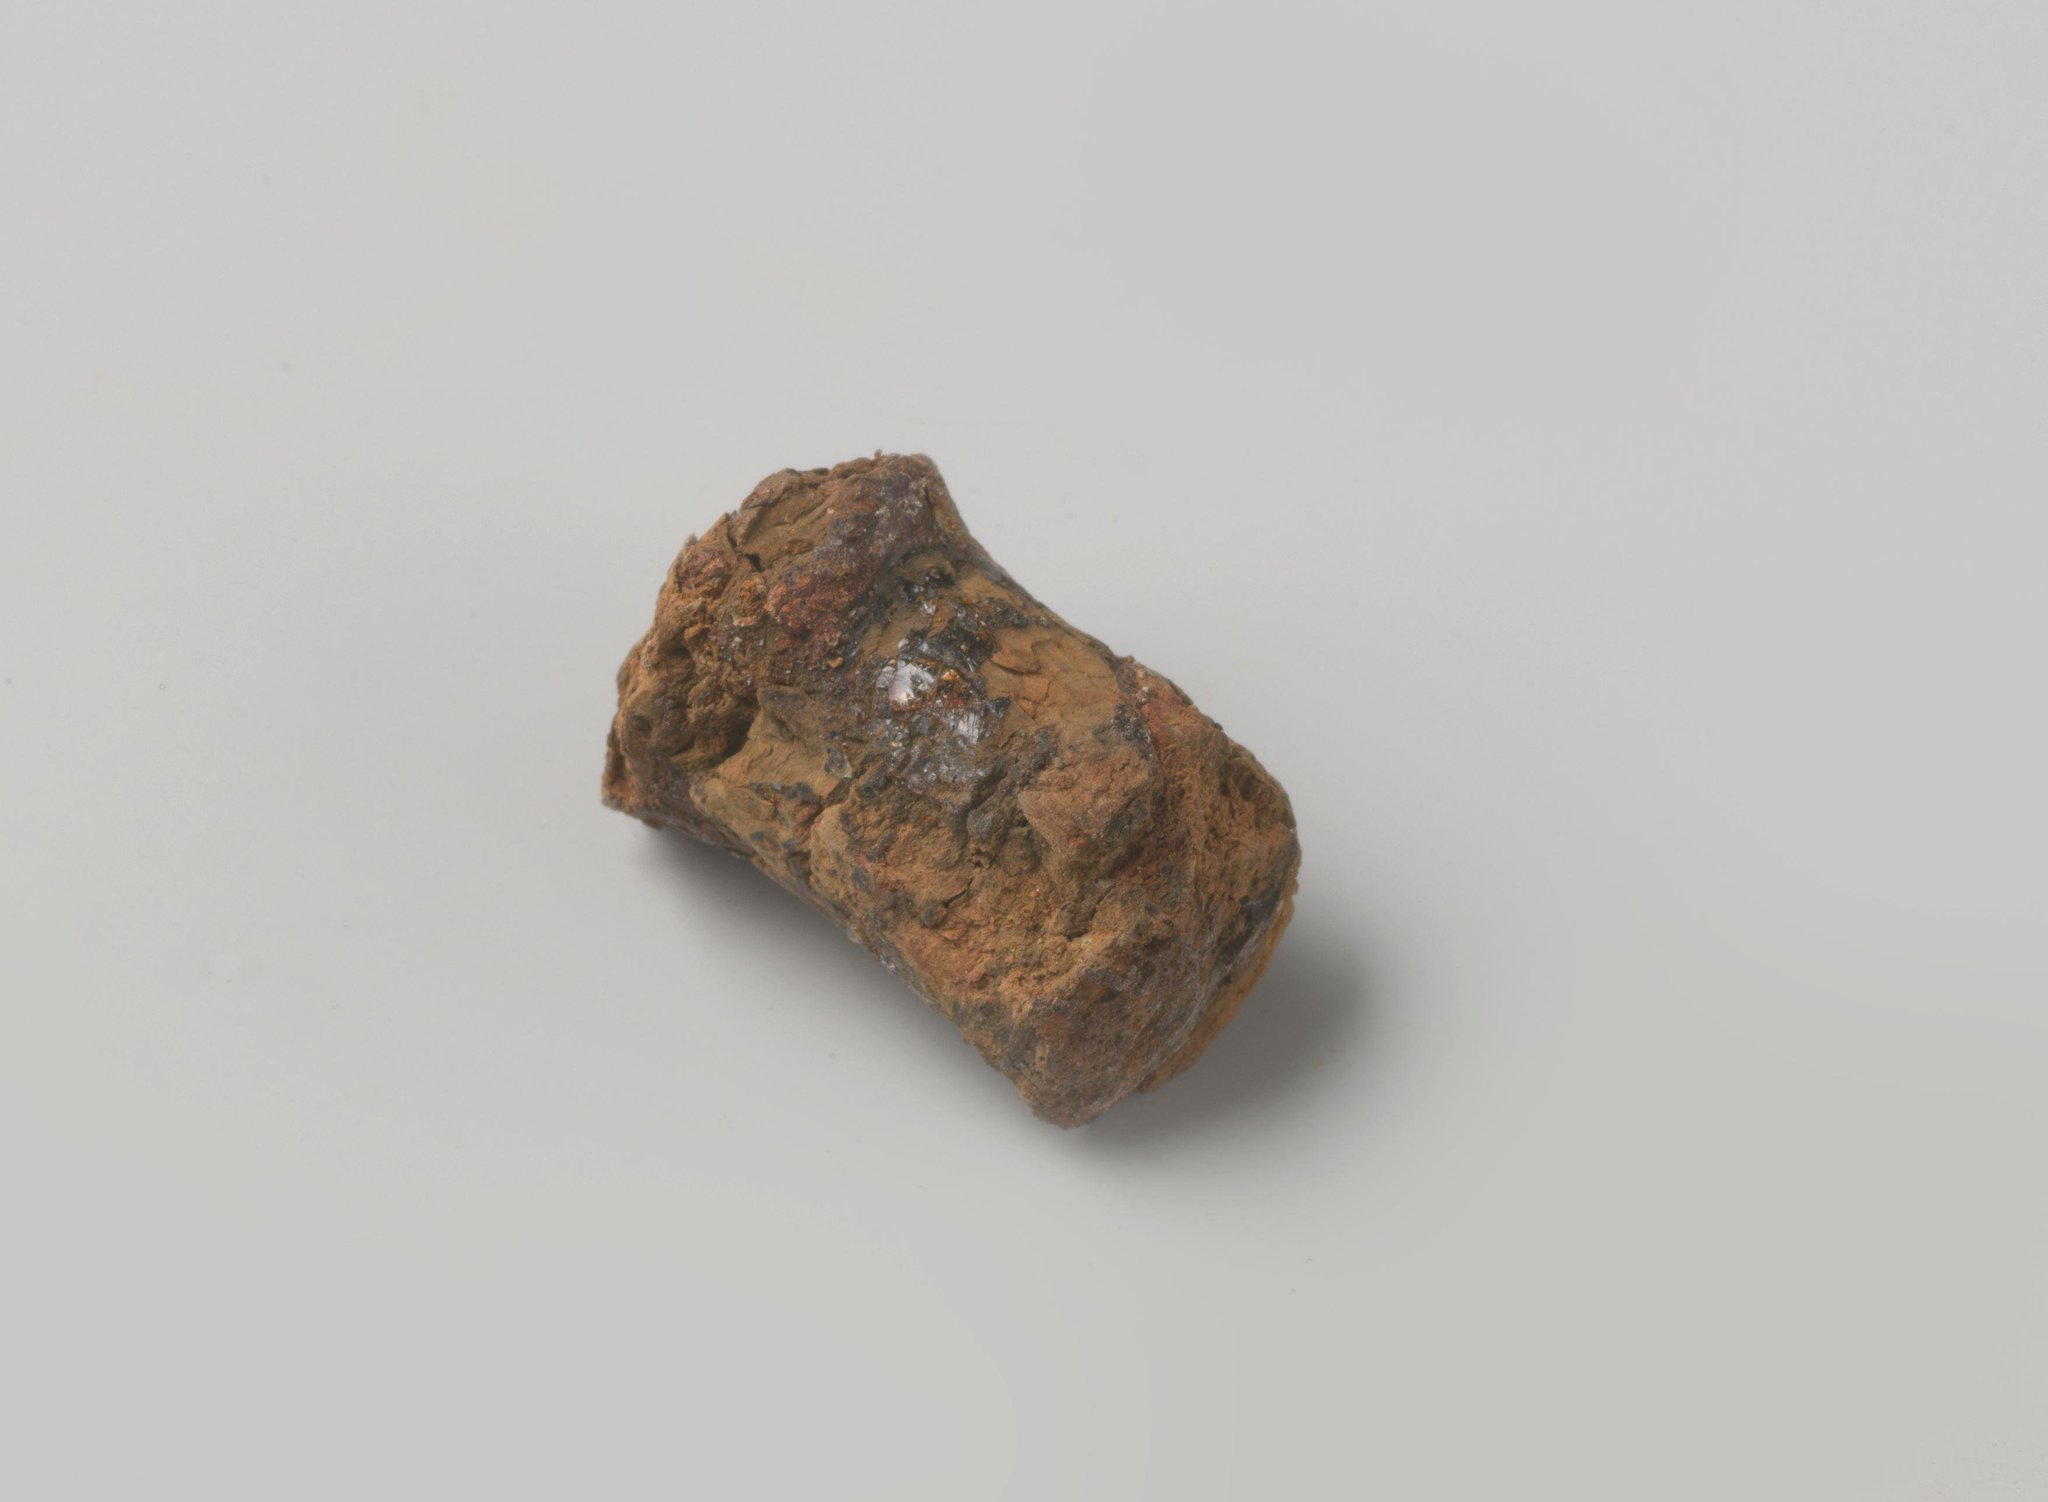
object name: wine bottle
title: Kurk van een wijnfles uit het wrak van de Oost-Indiëvaarder Hollandia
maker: Anonymous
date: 1700-1743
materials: cork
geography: netherlands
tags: verenigde oostindische compagnie, hollandia (schip), annet